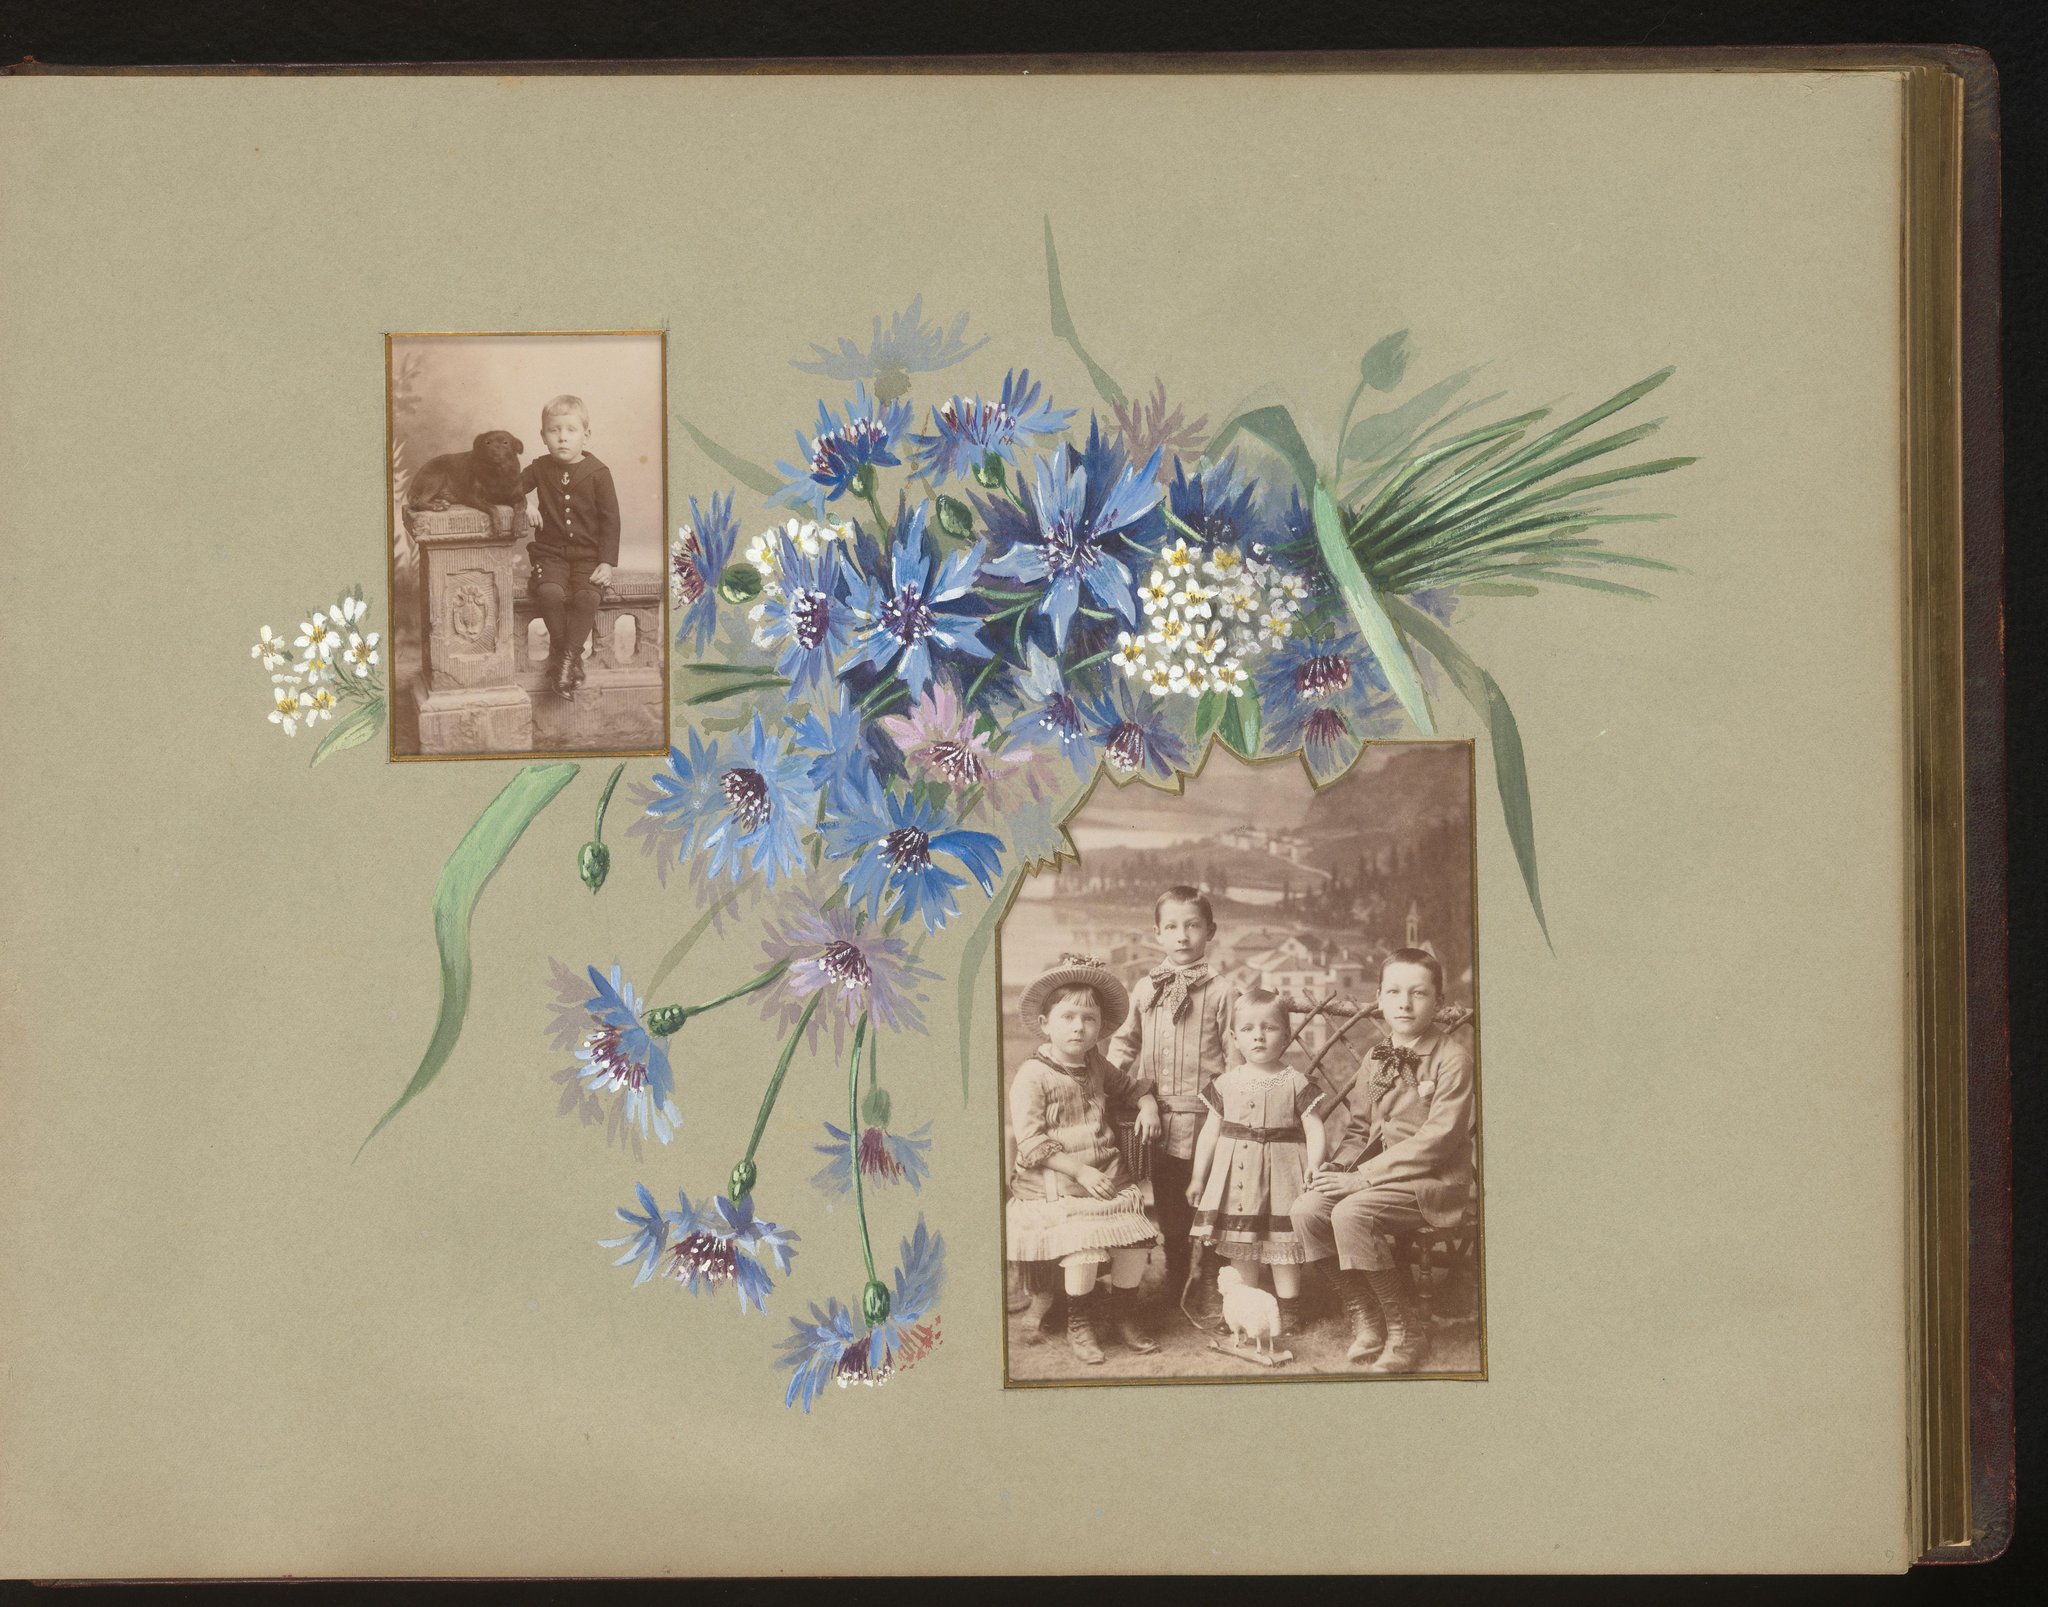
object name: album leaf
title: Portret van een jongen met een hond, vermoedelijk Ernst Zeller en portret van vier kinderen, vermoedelijk Martha, Carl, Emil en Moritz Zeller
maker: Anonymous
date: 1872-1897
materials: paint, photographic support, watercolor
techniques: albumen print, brush, hand coloring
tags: boy (child between toddler and youth), girl (child between toddler and youth), brothers or sisters (second degree family relationships), dog